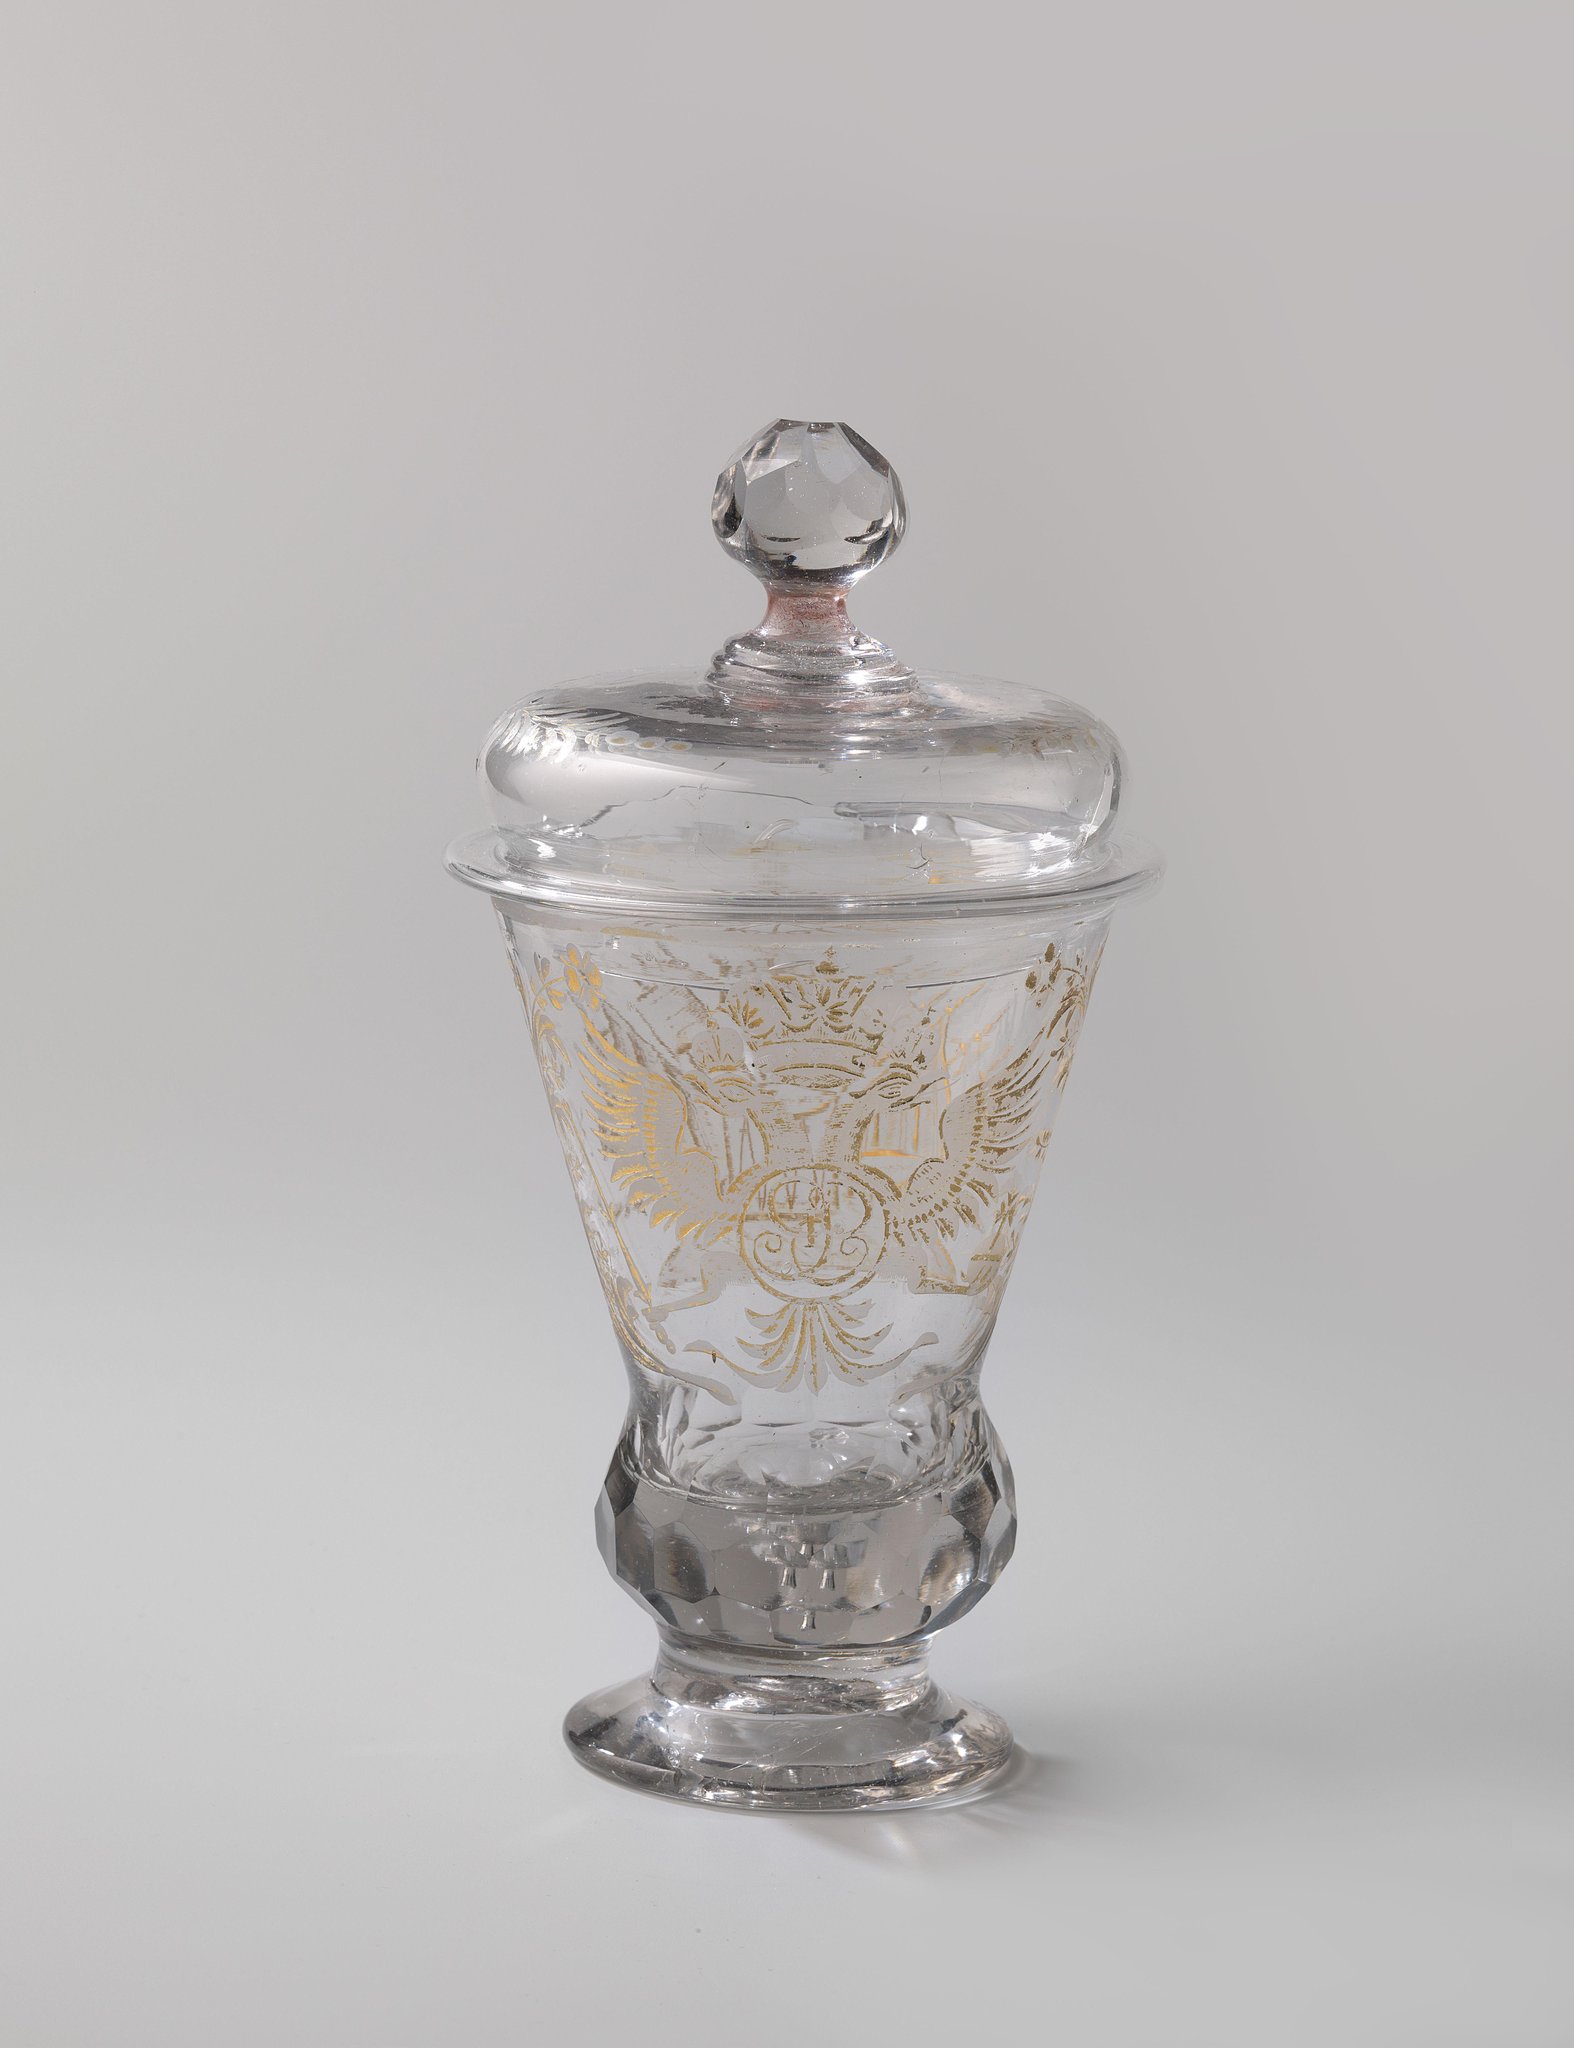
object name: lid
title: Deksel van beker op voet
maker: Anonymous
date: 1750-1800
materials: glass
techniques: glassblowing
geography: germany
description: Op de deksel een bladornament. De radgravure is verguld.